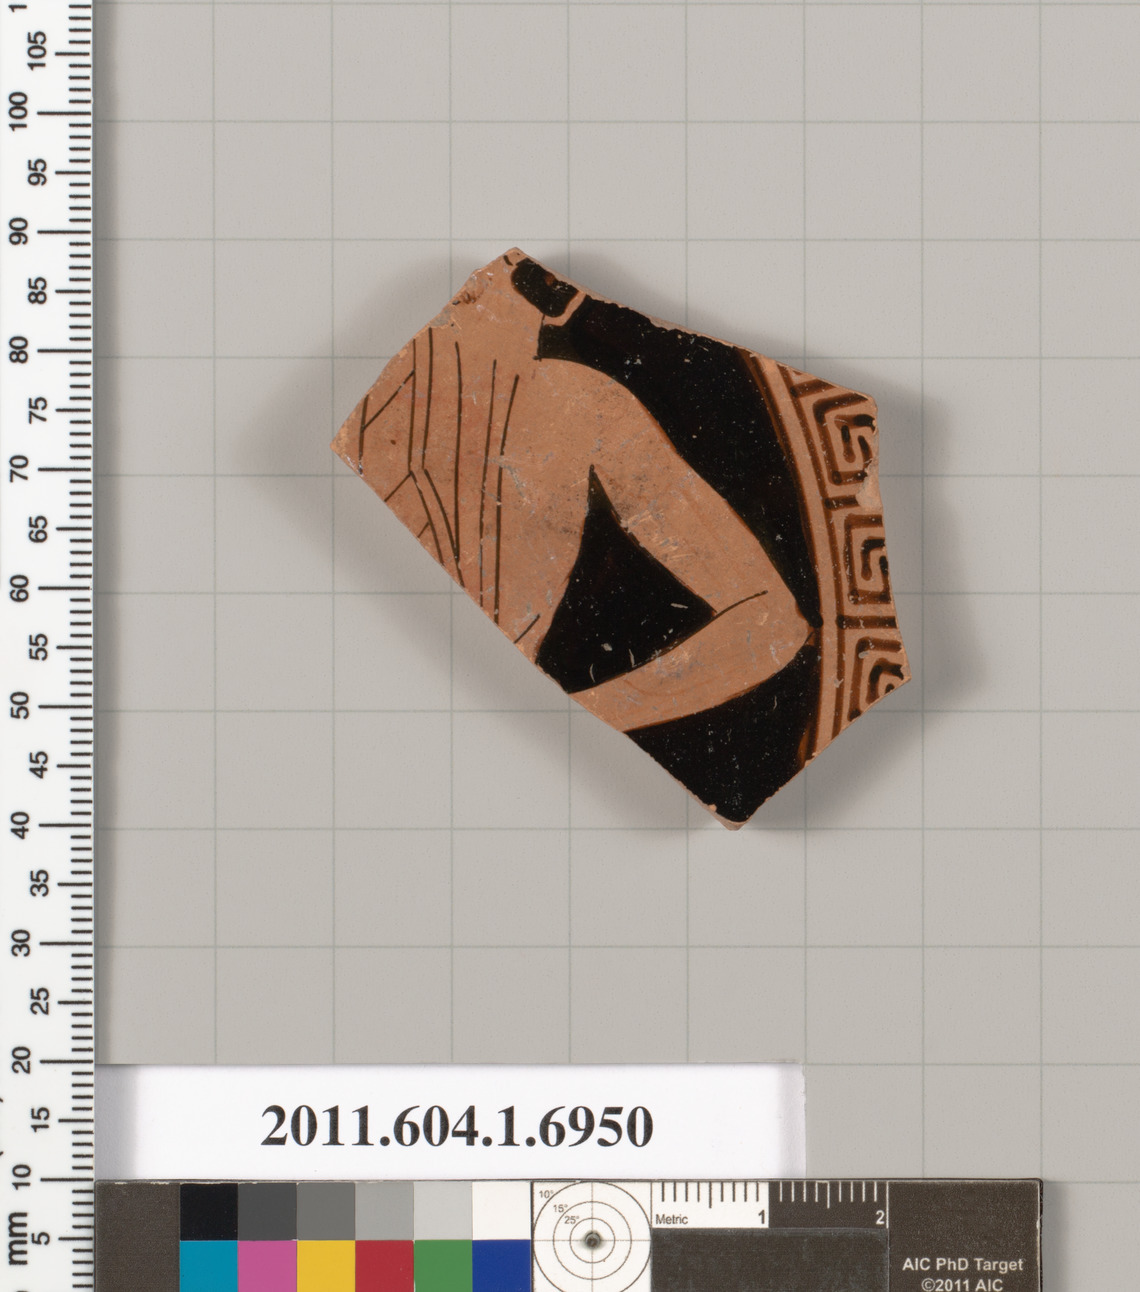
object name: kylix fragment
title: Terracotta fragment of a kylix (drinking cup)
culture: greek, attic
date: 490-470 BCE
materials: terracotta